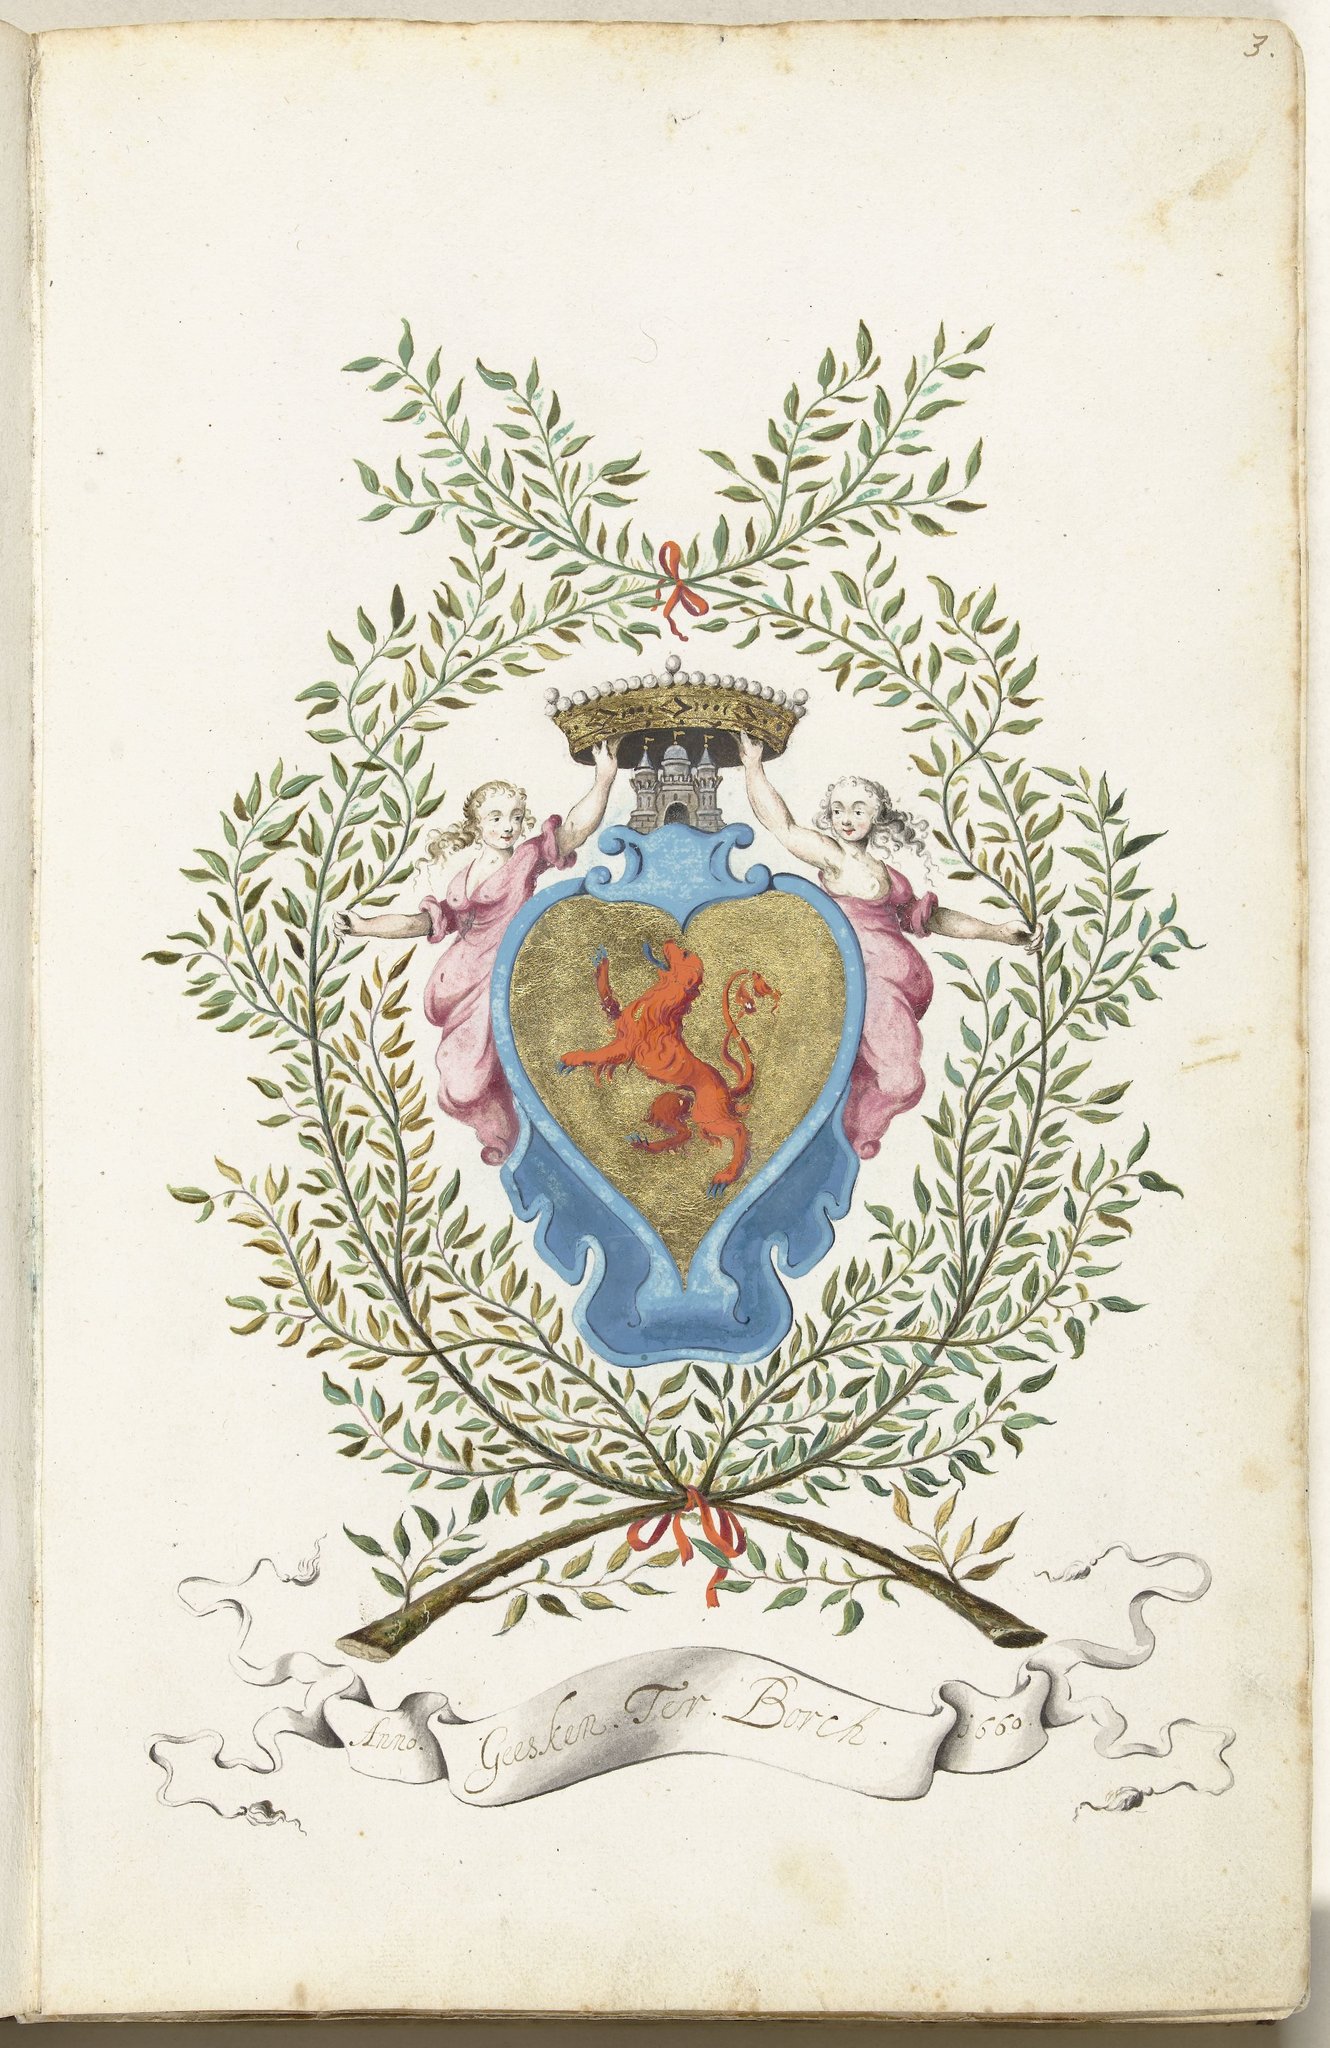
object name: watercolor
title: Wapen van de familie Ter Borch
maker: gesina ter borch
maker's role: draughtsman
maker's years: 1633-1690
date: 1660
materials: paper, watercolor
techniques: brush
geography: zwolle